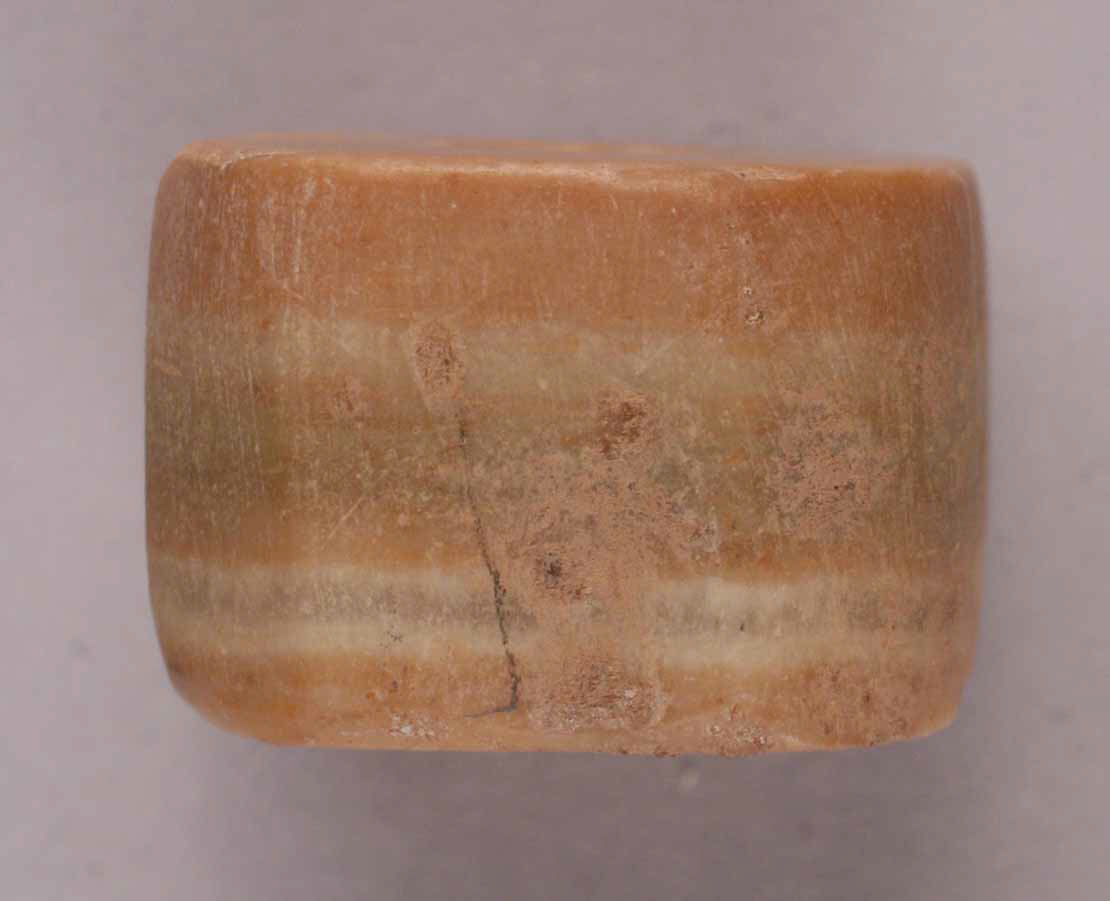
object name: bead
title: Beads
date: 701-1300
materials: stone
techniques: cutting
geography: iran